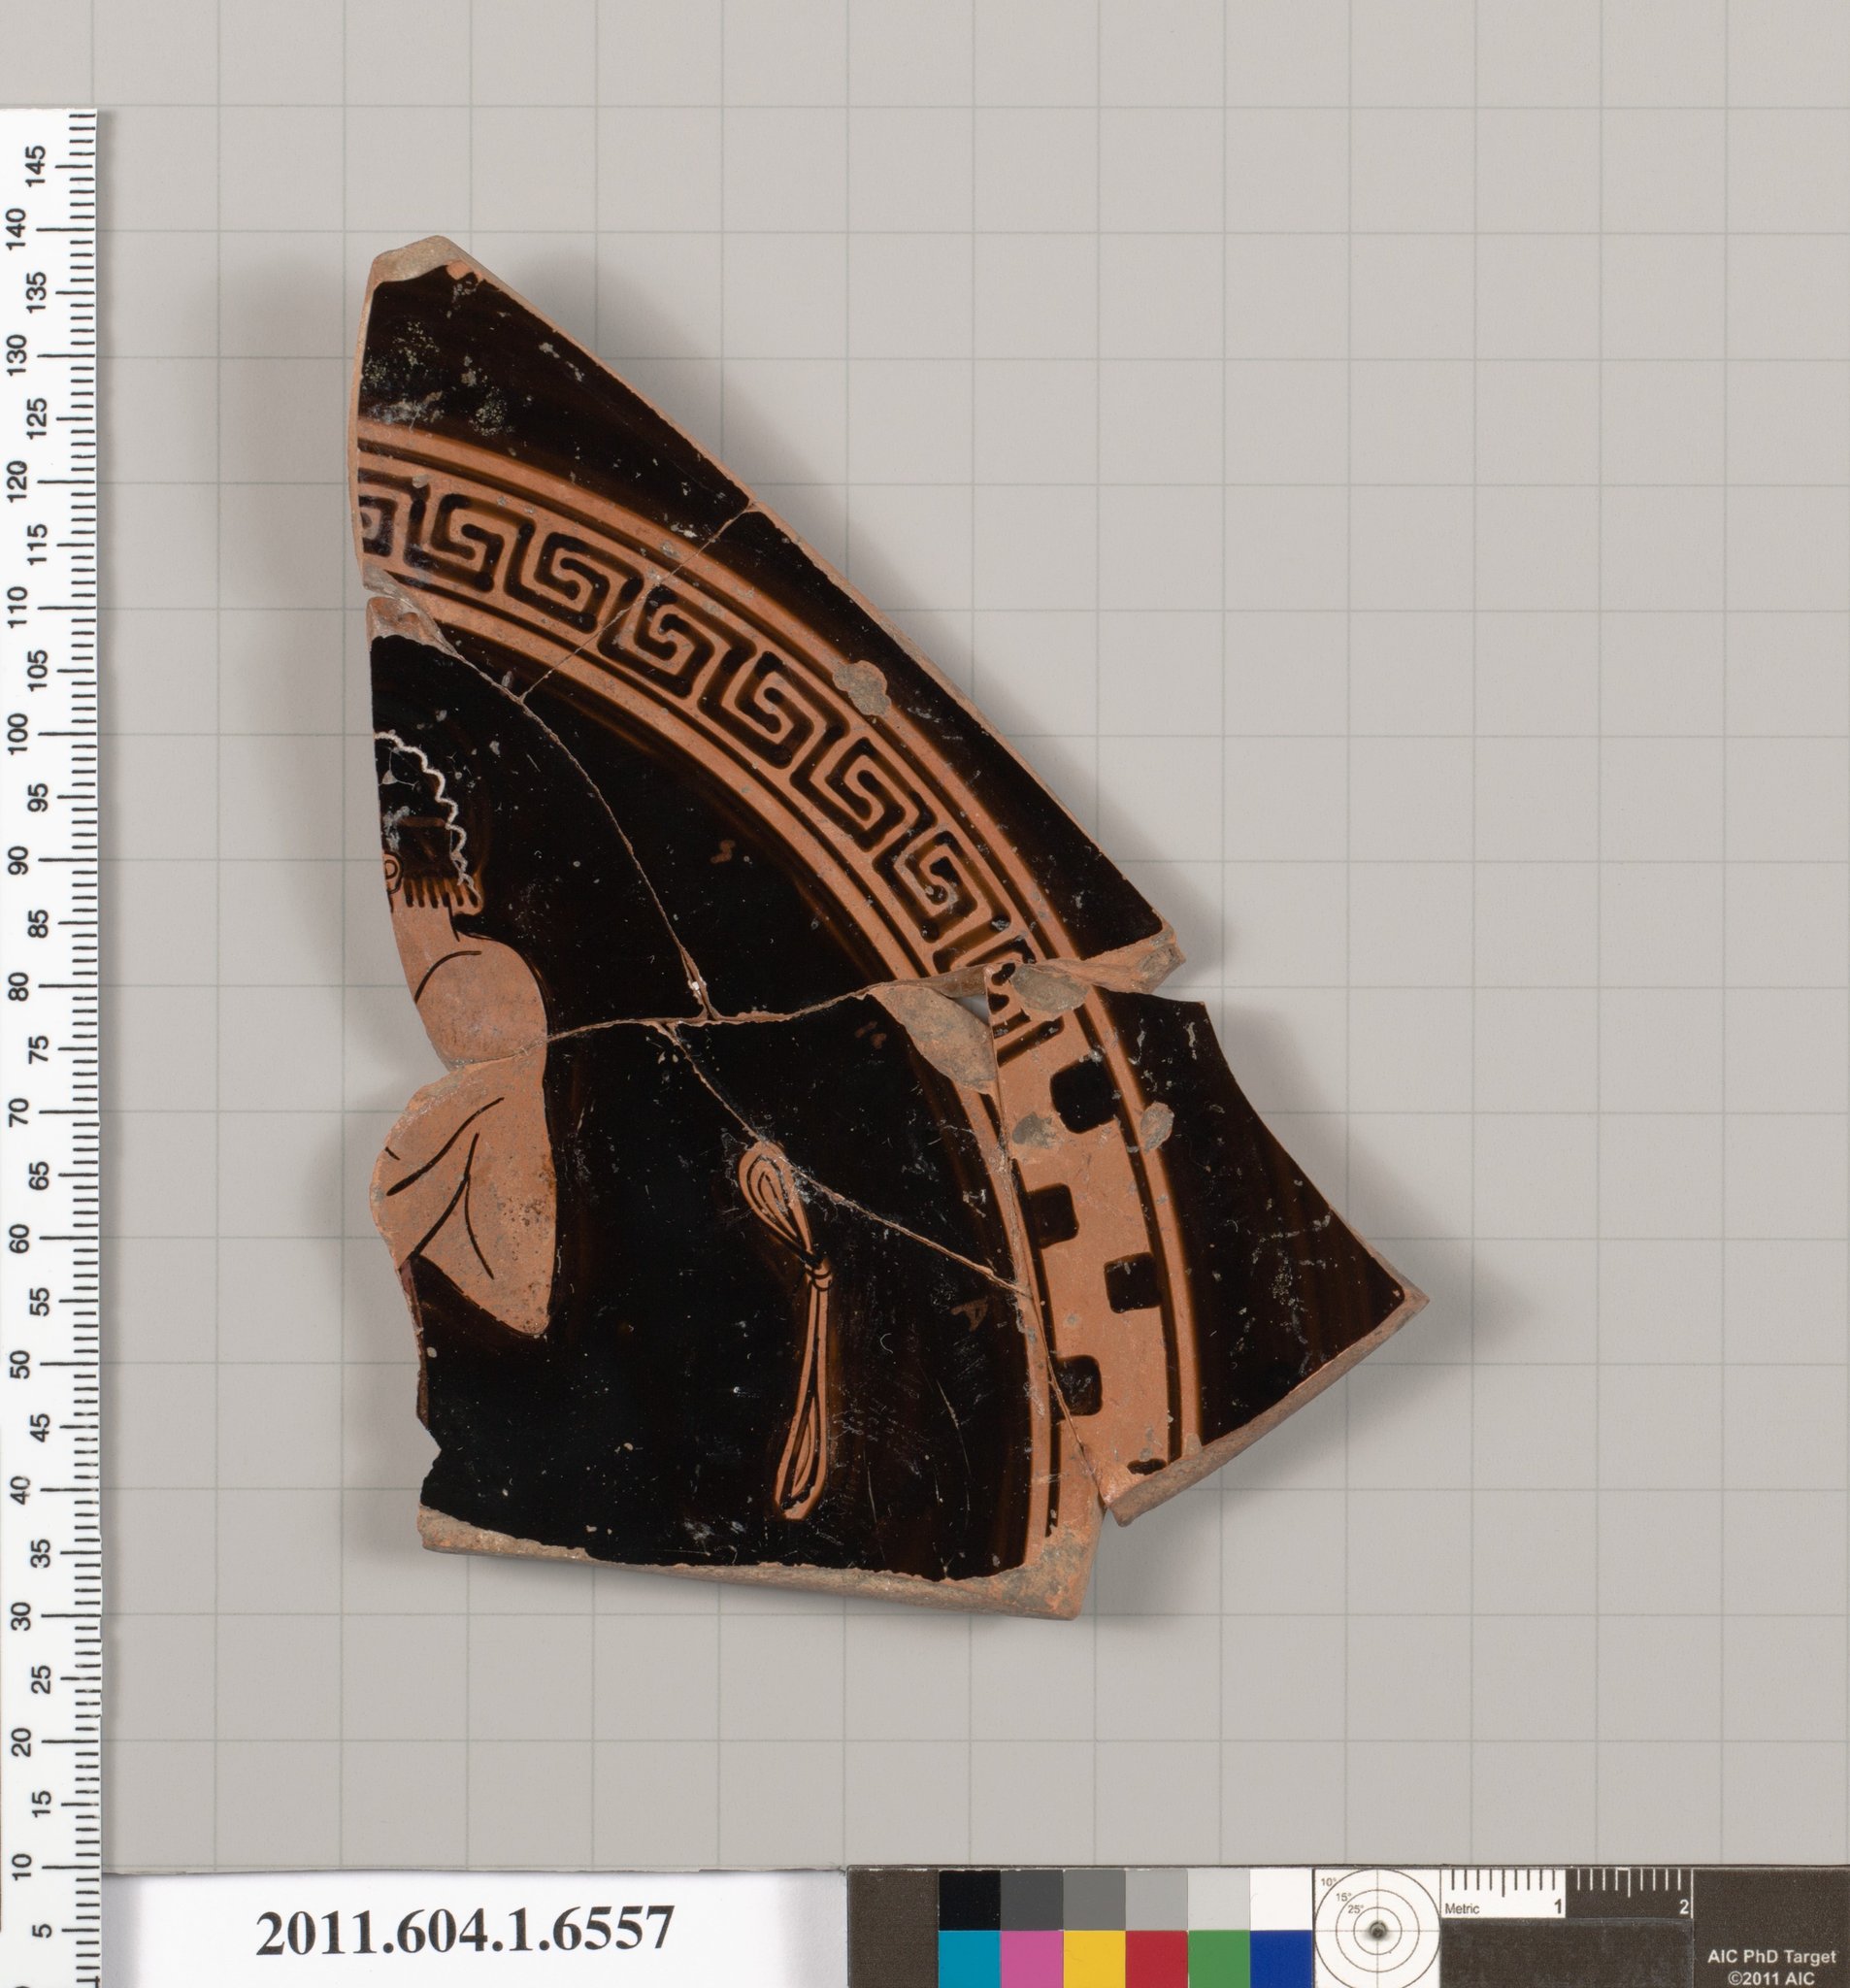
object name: kylix fragment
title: Terracotta fragment of a kylix (drinking cup)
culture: greek, attic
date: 490-480 BCE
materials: terracotta